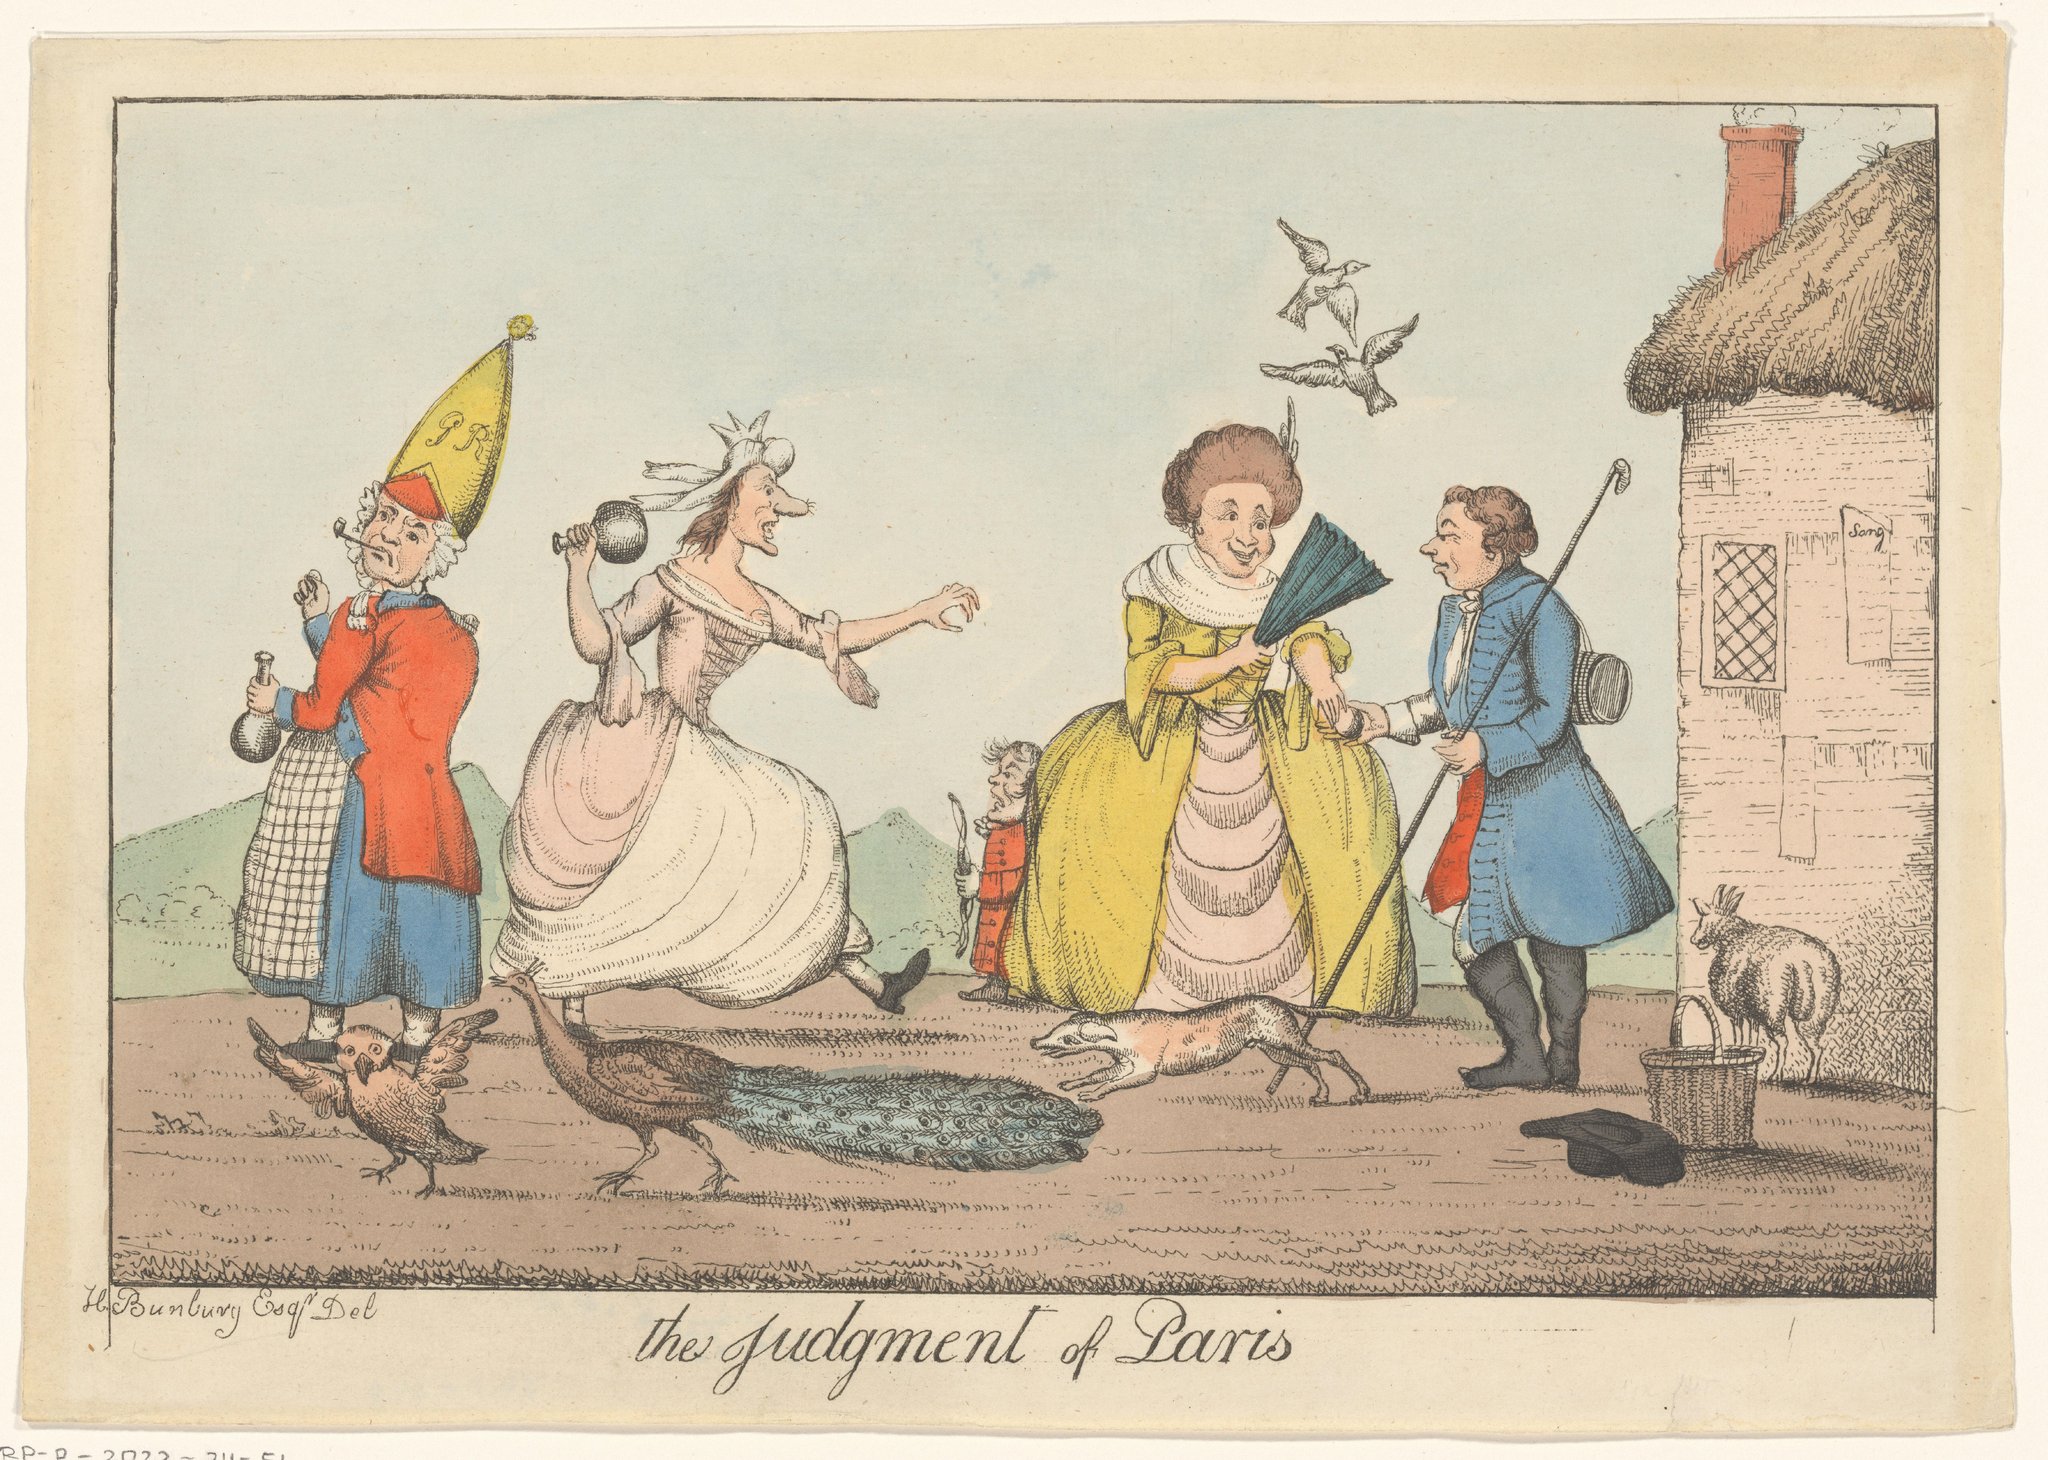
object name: cartoon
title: The Judgment of Paris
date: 1766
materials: paper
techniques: etching, hand coloring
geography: europe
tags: the judgement of paris (without mercury), caricatures (human types)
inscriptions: collector's mark: Lugt 2228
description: Satire op plattelandsmensen. Buiten een huisje met rieten dak staat ‘Paris’, een arme jonge herder die een appel overhandigt aan een overgeklede 'Venus' met waaier en brede hoepelrok. Twee duiven vliegen boven haar hoofd. 'Cupido', een kleine jongen met een boog, staat naast haar, gedeeltelijk verborgen door haar rok. 'Juno' komt hen tegemoet, zwaaiend met een fles, haar pauw aan haar voeten. 'Minerva' in een soldatenjas en grenadierspet, met inscriptie "J.R." en een uil aan haar voeten, loopt naar links weg met een gebalde en vuist en pijp in de mond. Achter Paris staat een schaap en zijn hond jaagt op de pauw en de uil.